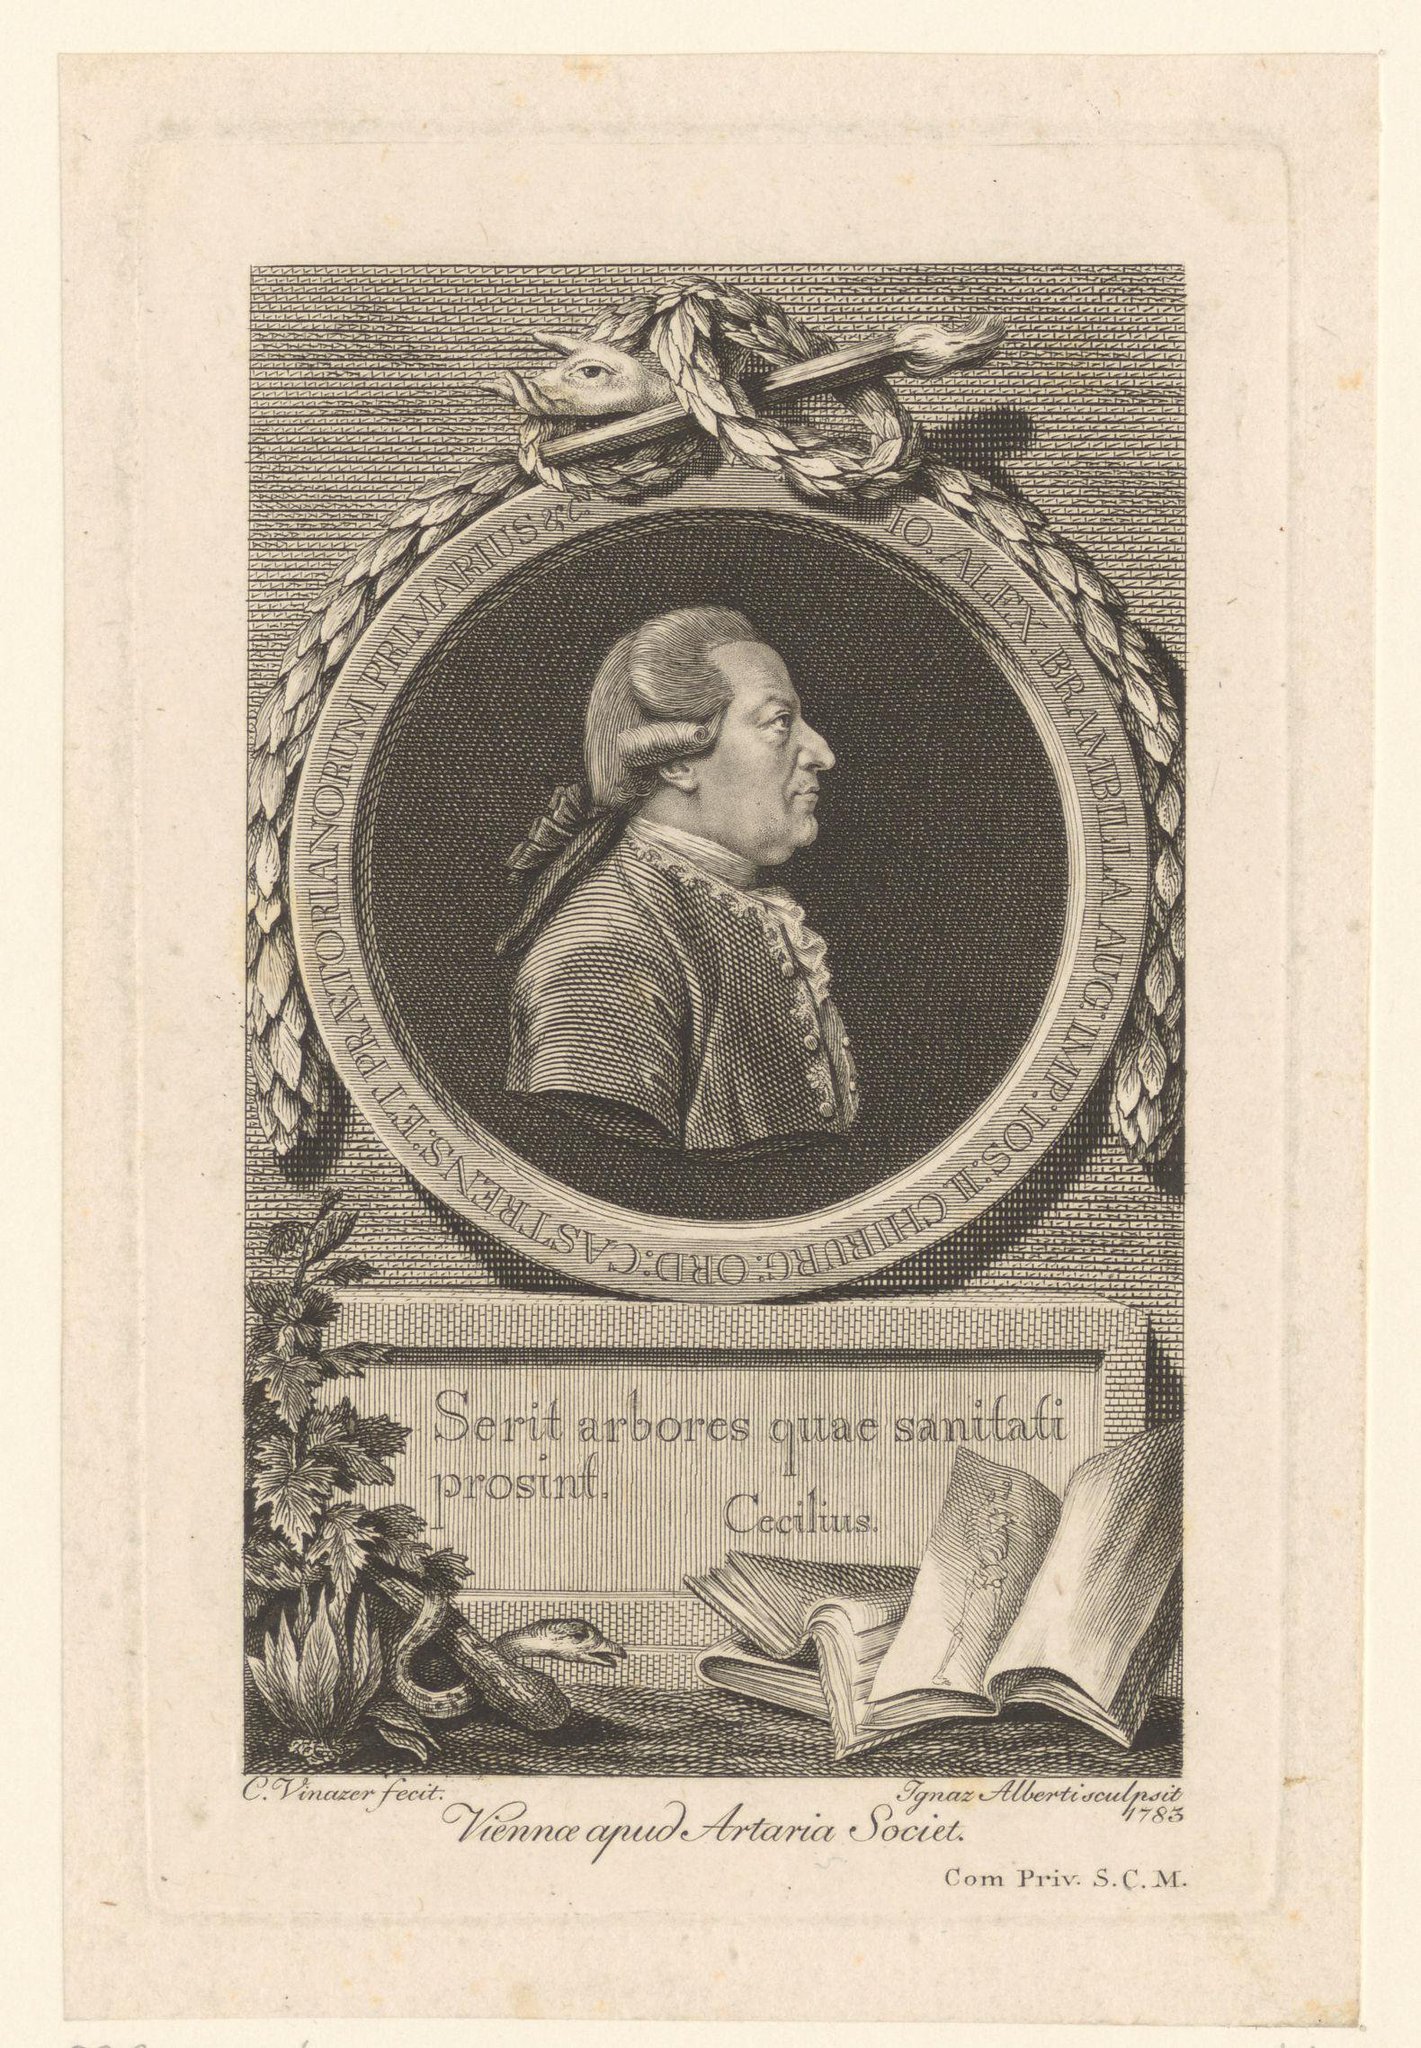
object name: print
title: Portret van Johann Alexander von Brambilla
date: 1783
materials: paper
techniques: engraving, etching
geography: vienna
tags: historical persons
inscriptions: collector's mark: Lugt 2228